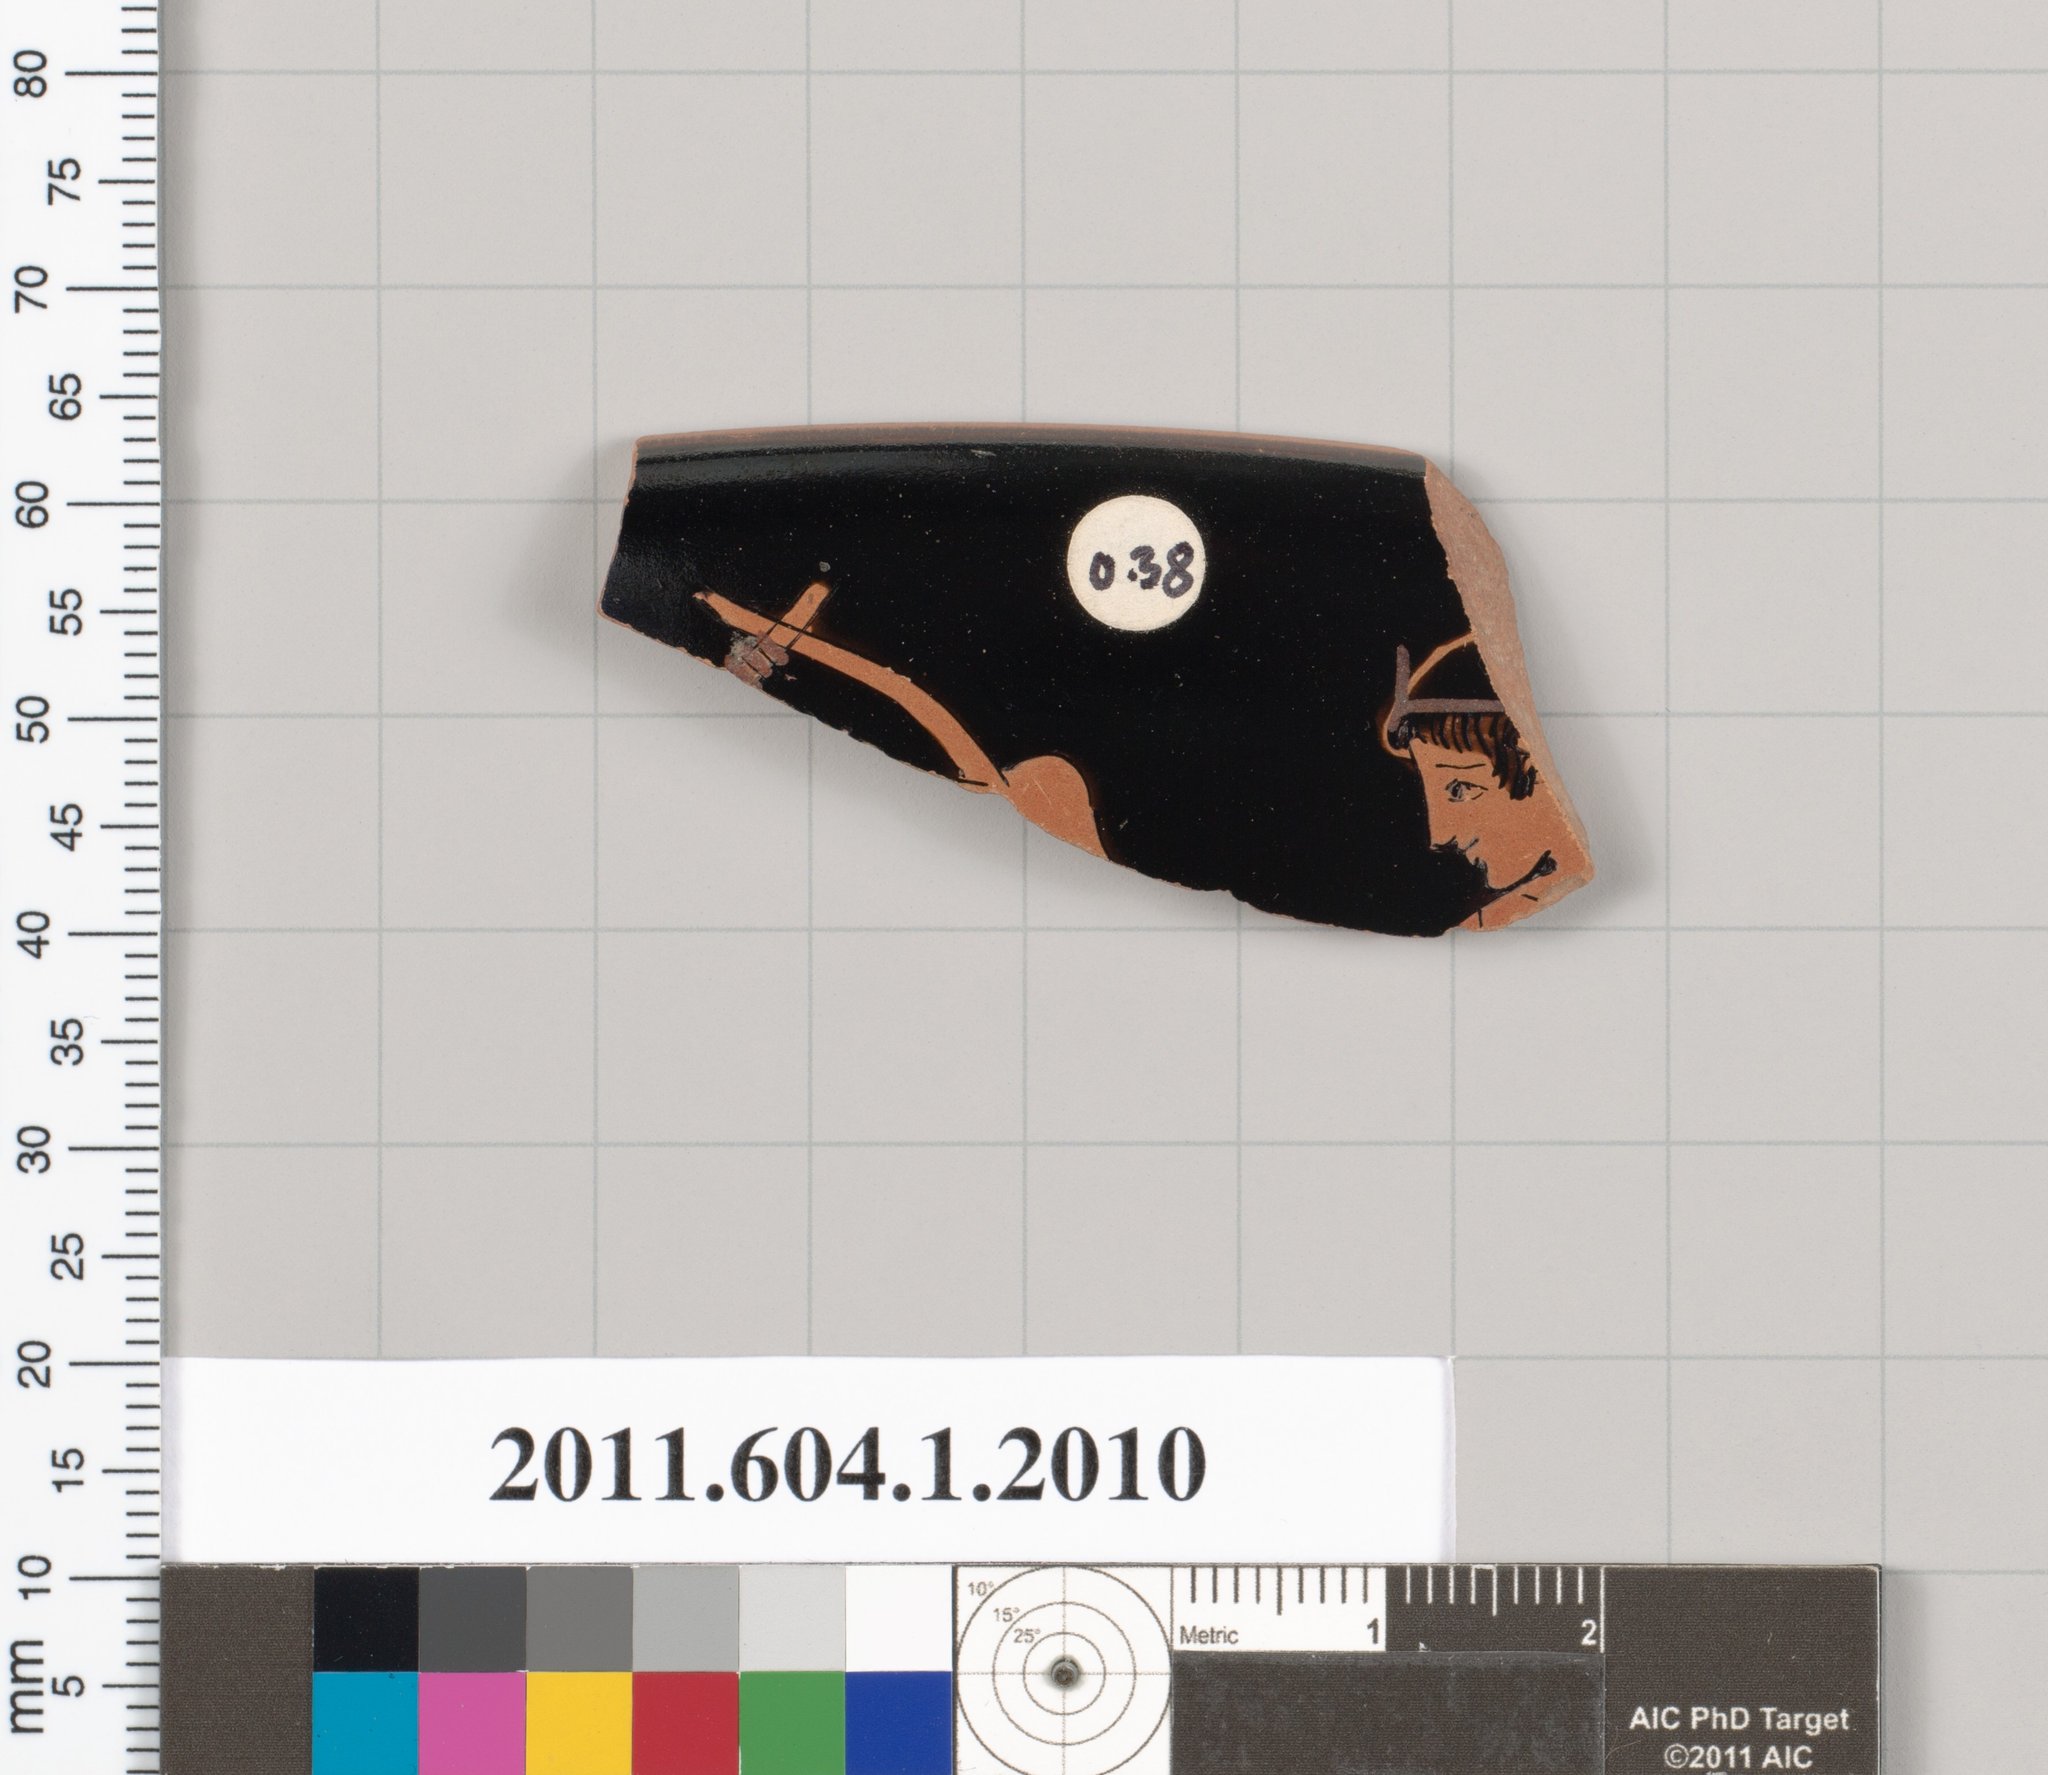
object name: kylix fragment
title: Terracotta rim fragment of a kylix (drinking cup)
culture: greek, attic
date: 475-451 BCE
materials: terracotta